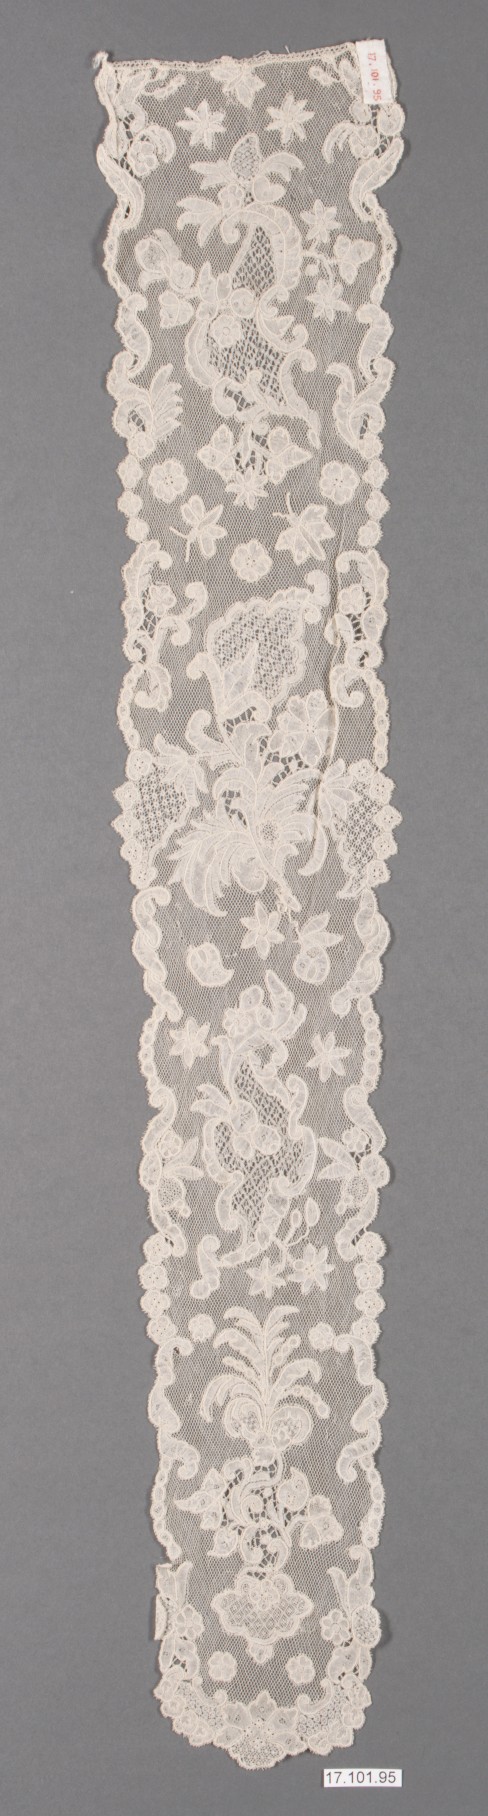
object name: lappet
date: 1701-1733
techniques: lace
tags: butterflies,flowers